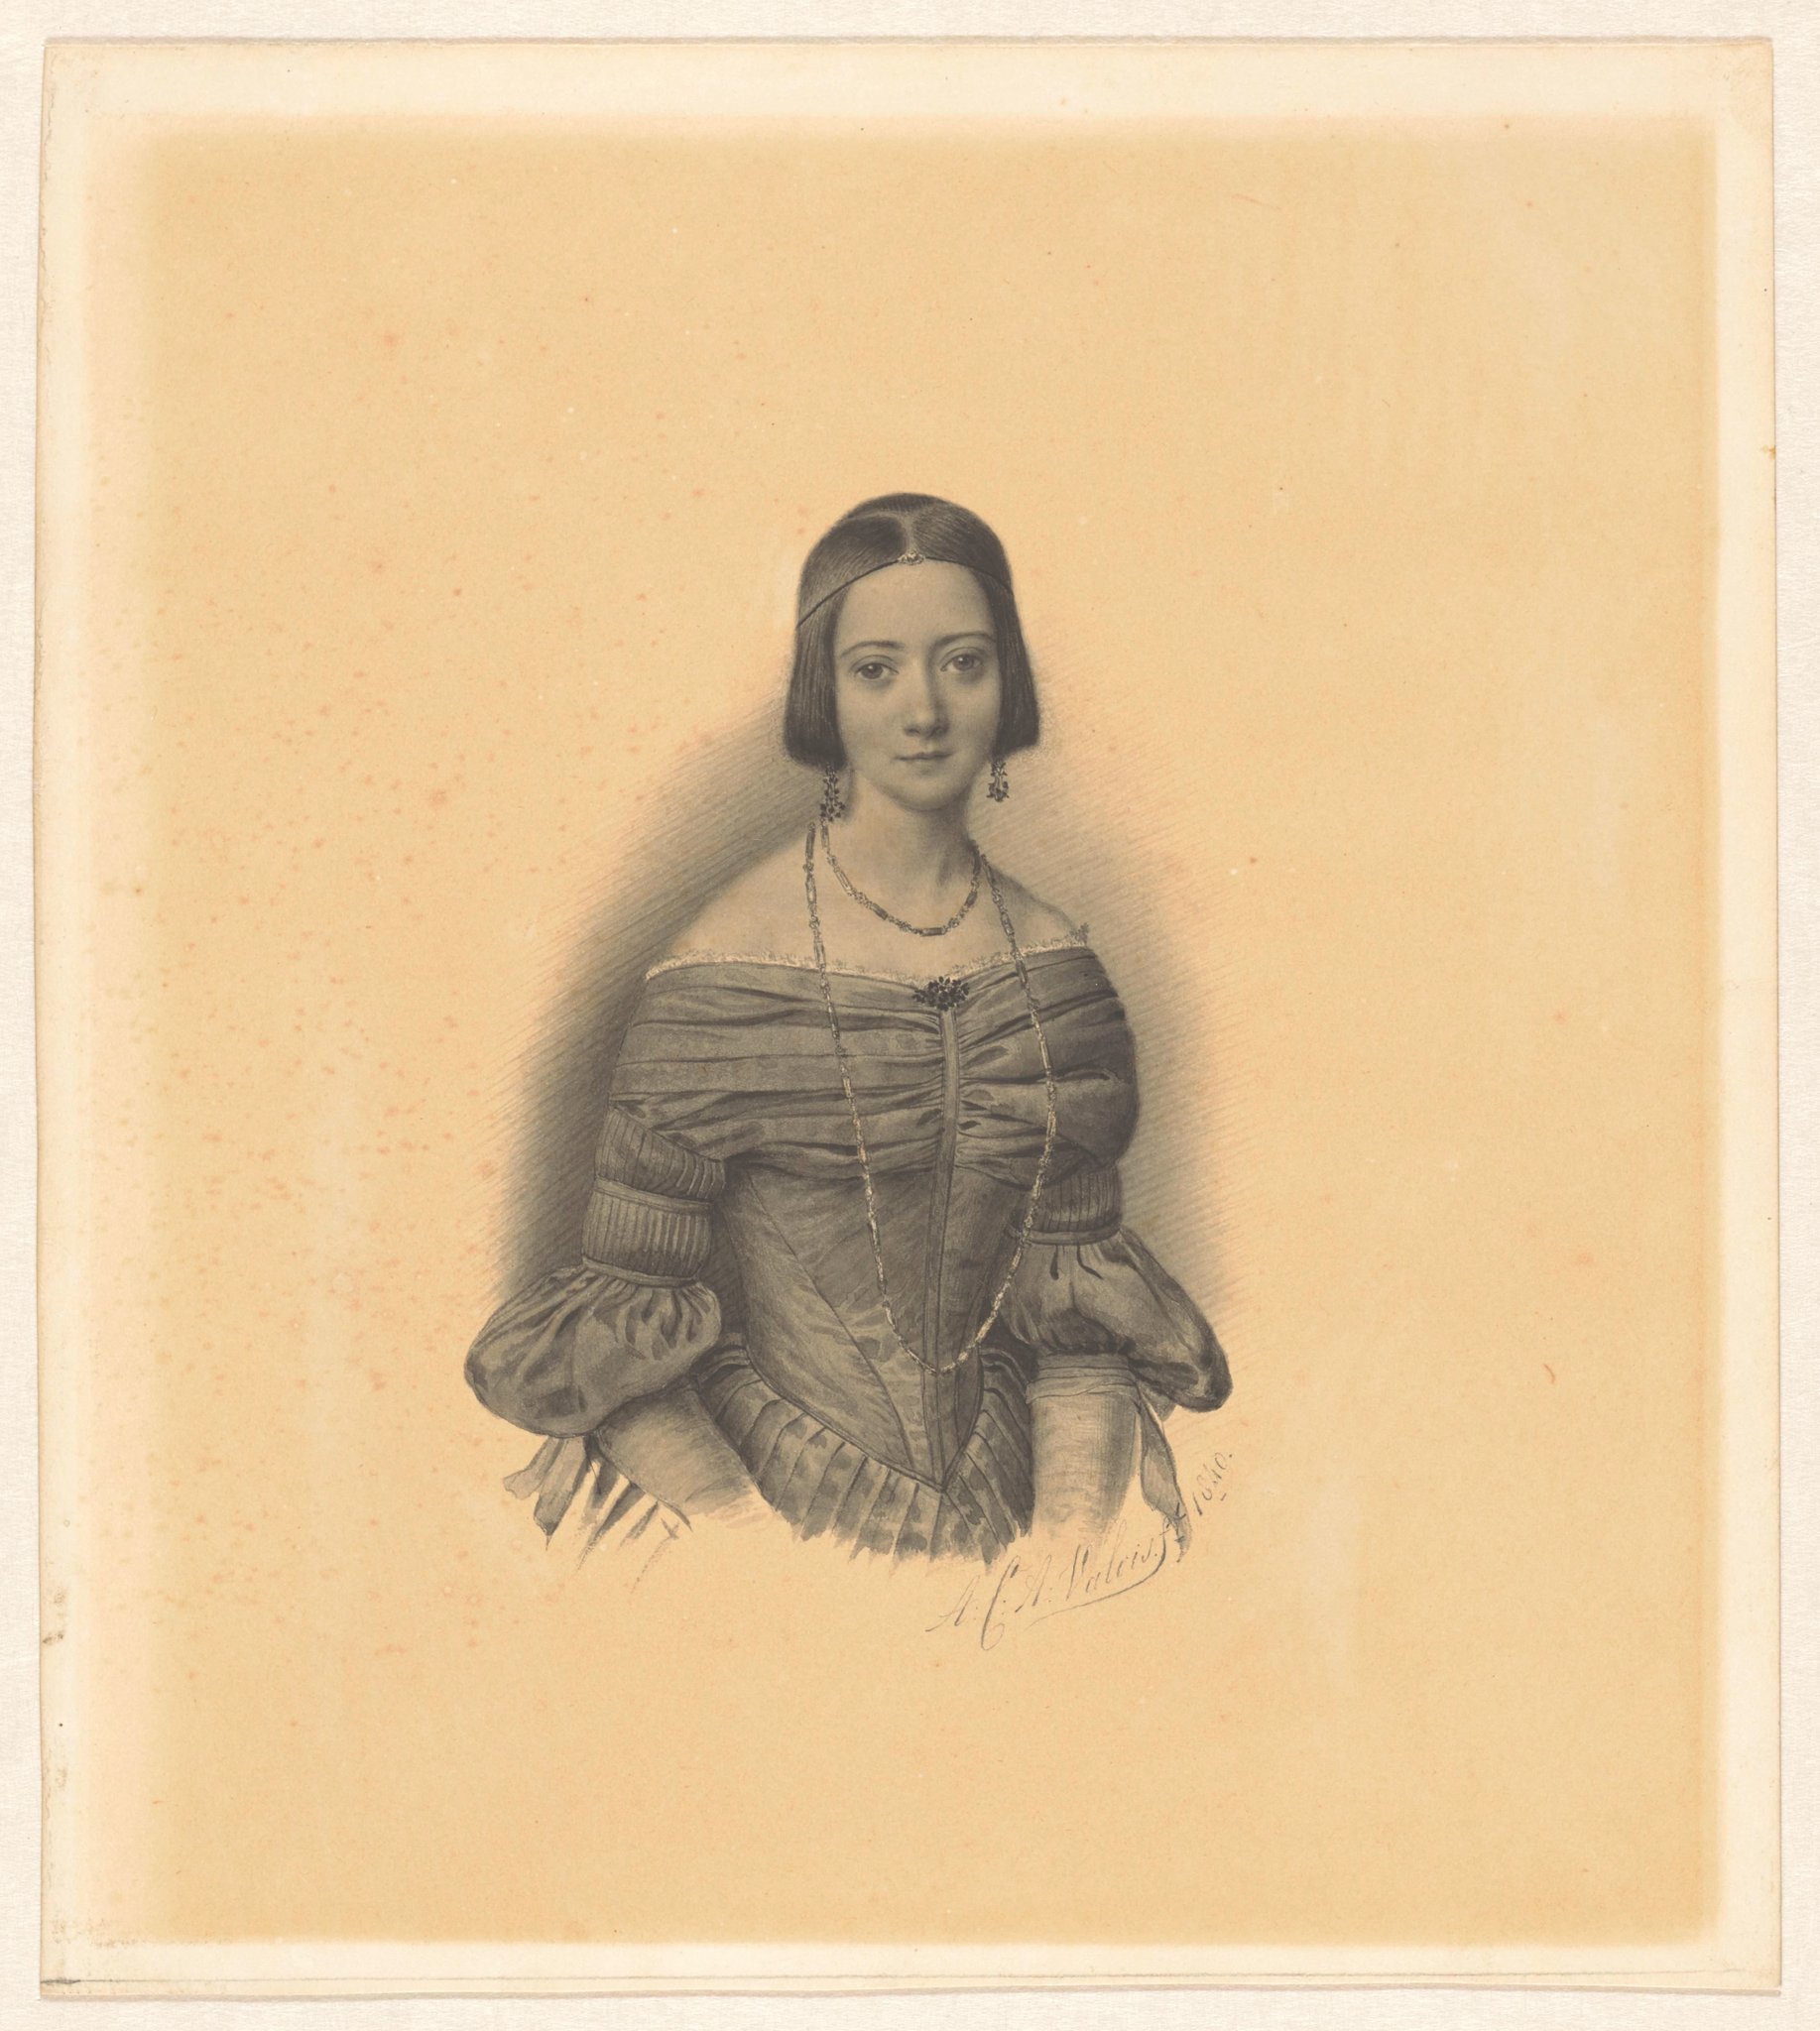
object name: drawing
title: Portret van Antoinette Marie Henriette Jeanne Reigersman, echtgenote van Jonkheer Mr Pieter van den Brandeler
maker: alexander cesar august valois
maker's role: draughtsman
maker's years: 1812-1876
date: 1840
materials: chalk, paper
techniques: brush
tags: antoinette marie henrietta jeanne reigersman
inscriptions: date